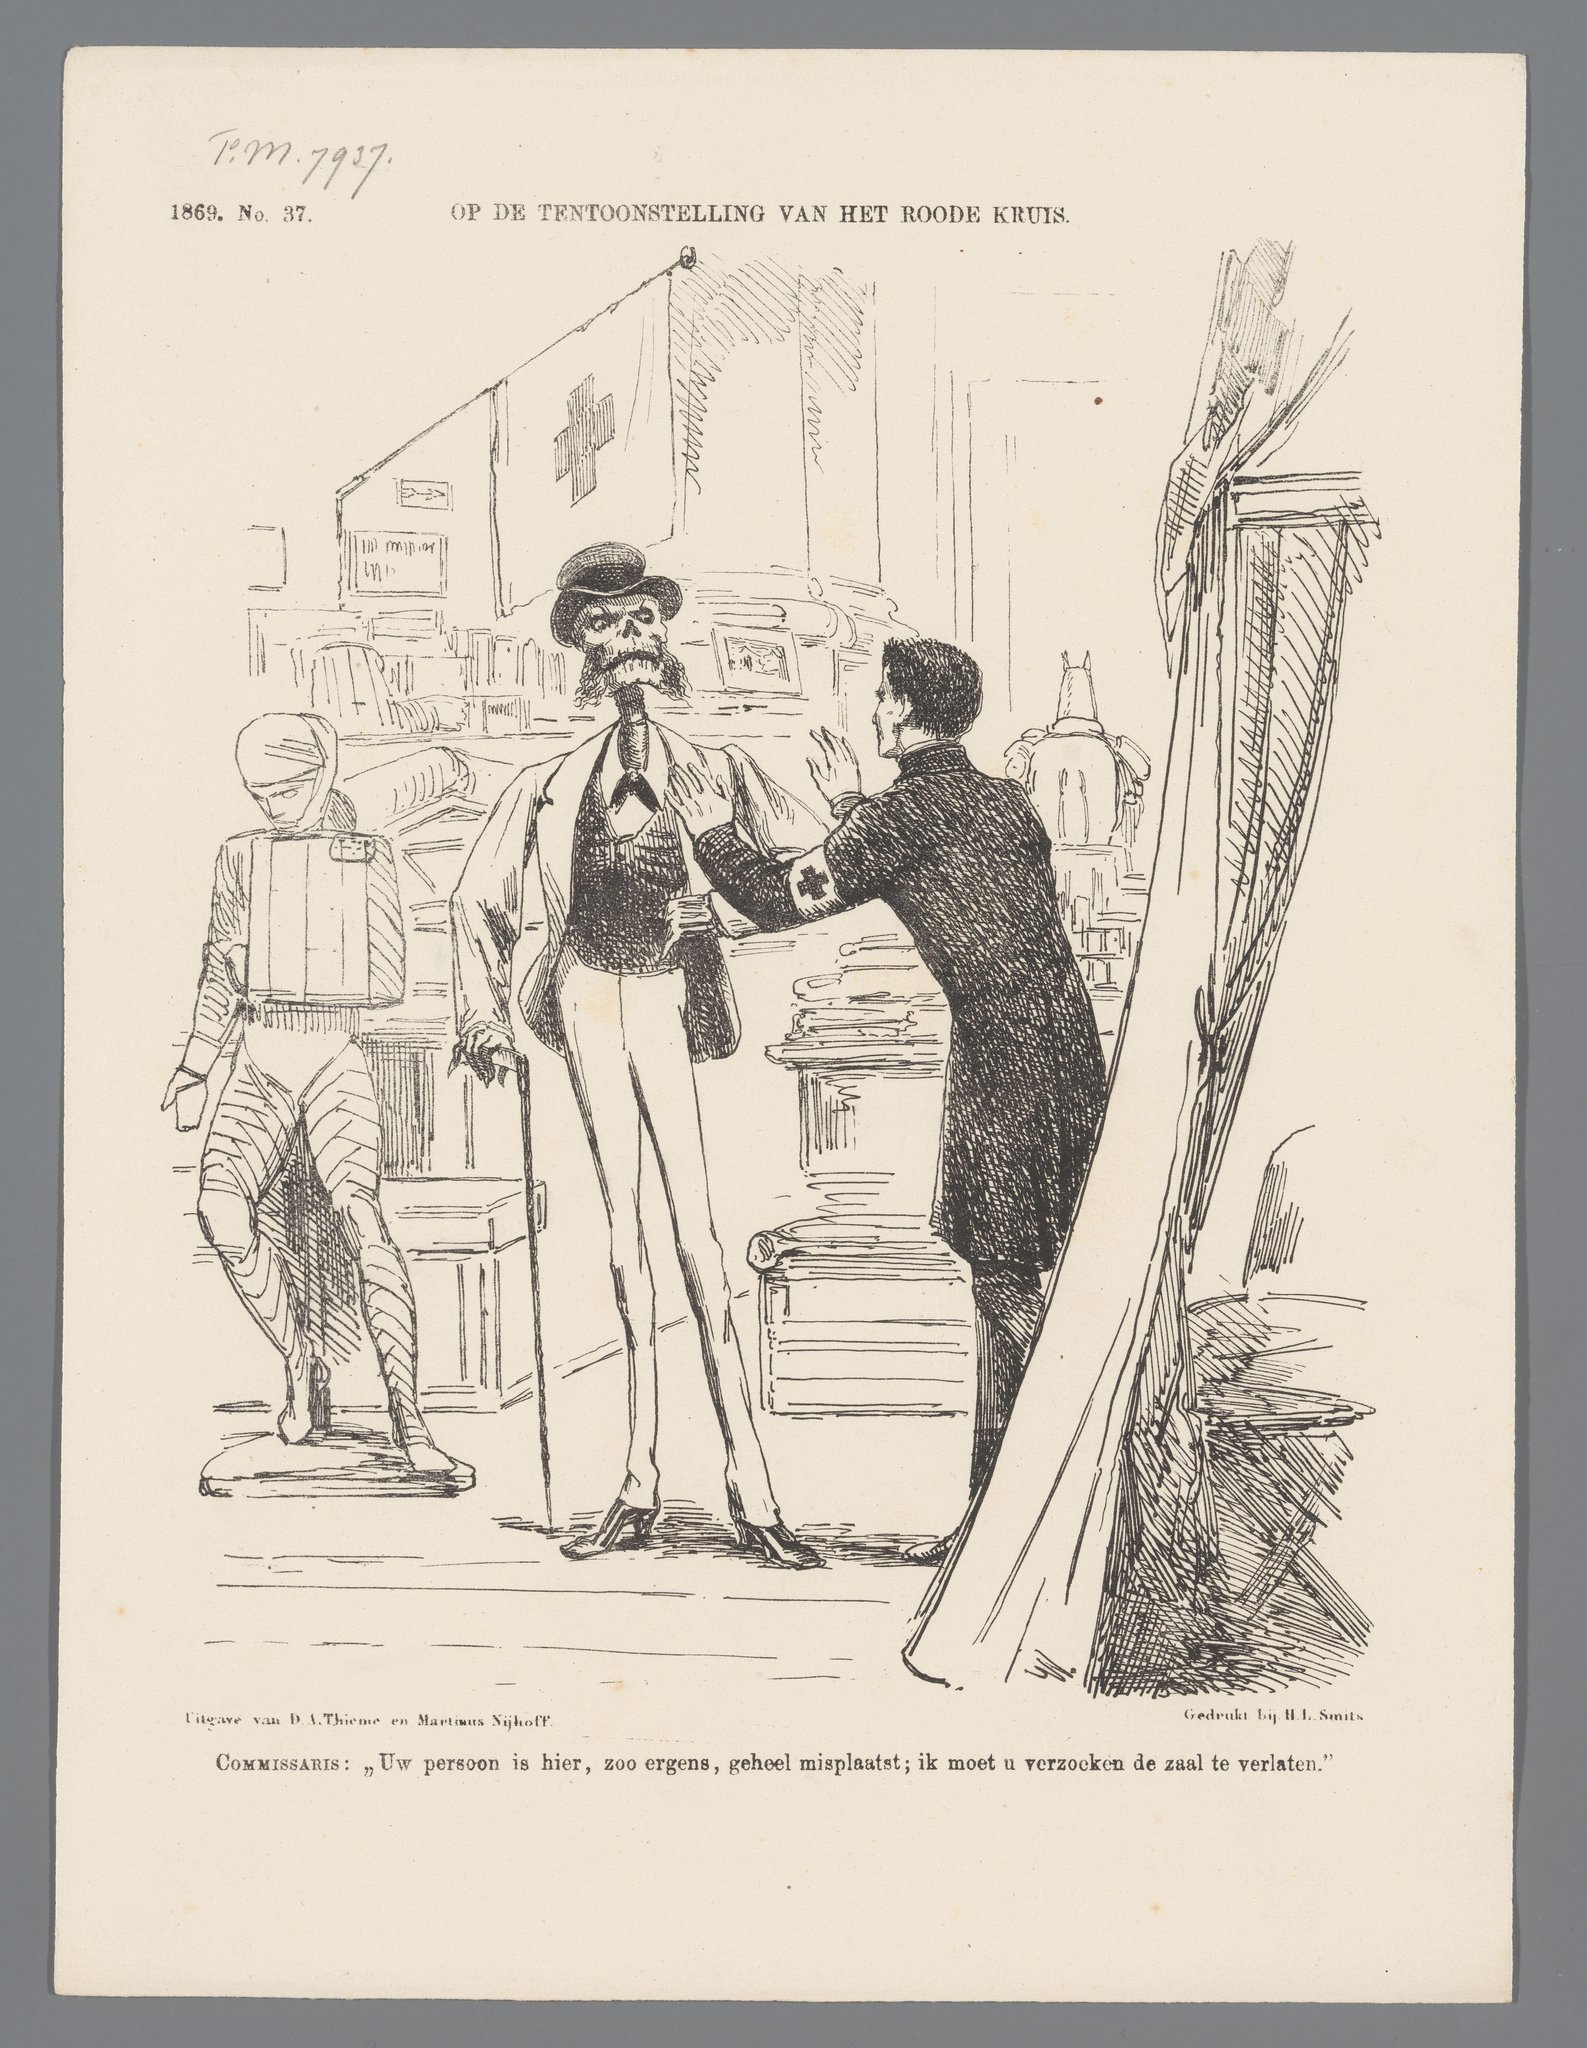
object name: cartoon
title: Spotprent op de tentoonstelling van het Rode Kruis, 1869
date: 1869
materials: paper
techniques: lithograph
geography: netherlands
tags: trade exhibition, industries fair, death as skeleton, the hague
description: Spotprent op de tentoonstelling van het Rode Kruis in Den Haag. De Dood wordt van de tentoonstelling weggestuurd. Plaat verschenen bij het weekblad De Nederlandsche Spectator, nr. 37, 1869.